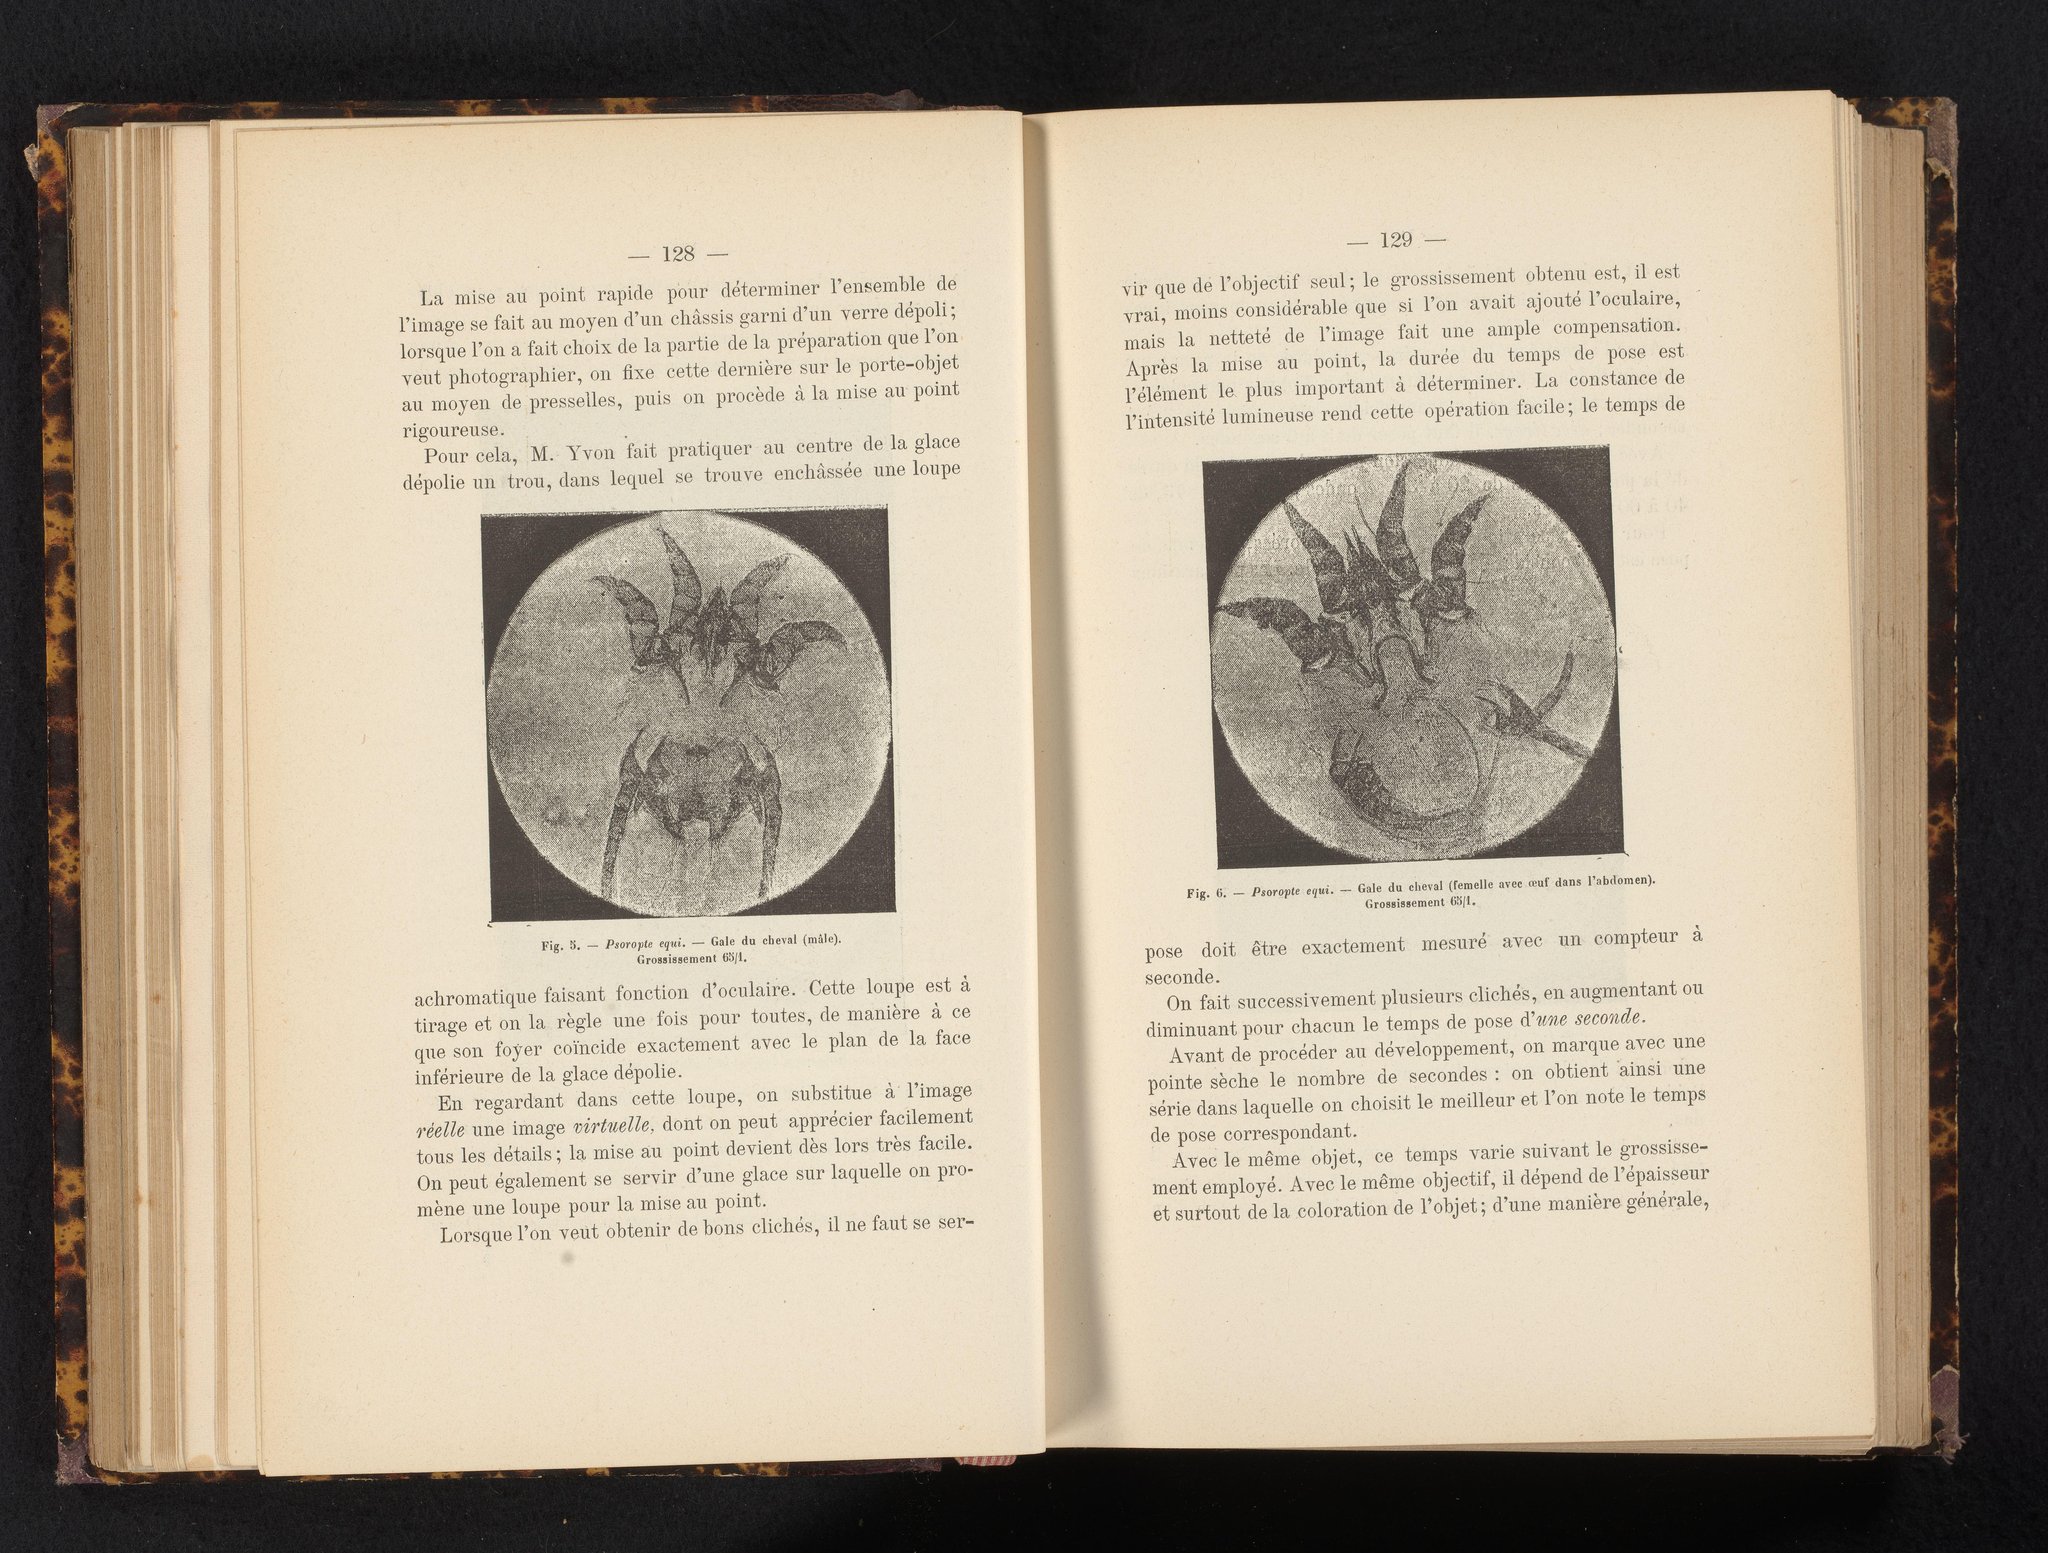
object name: micro opname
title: Psoropte equi.- Gale du cheval (mâle)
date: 1881-1886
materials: paper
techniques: autotype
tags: insects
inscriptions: inscription: ‘Fig. 5. (...) Grossissement 65/1.’